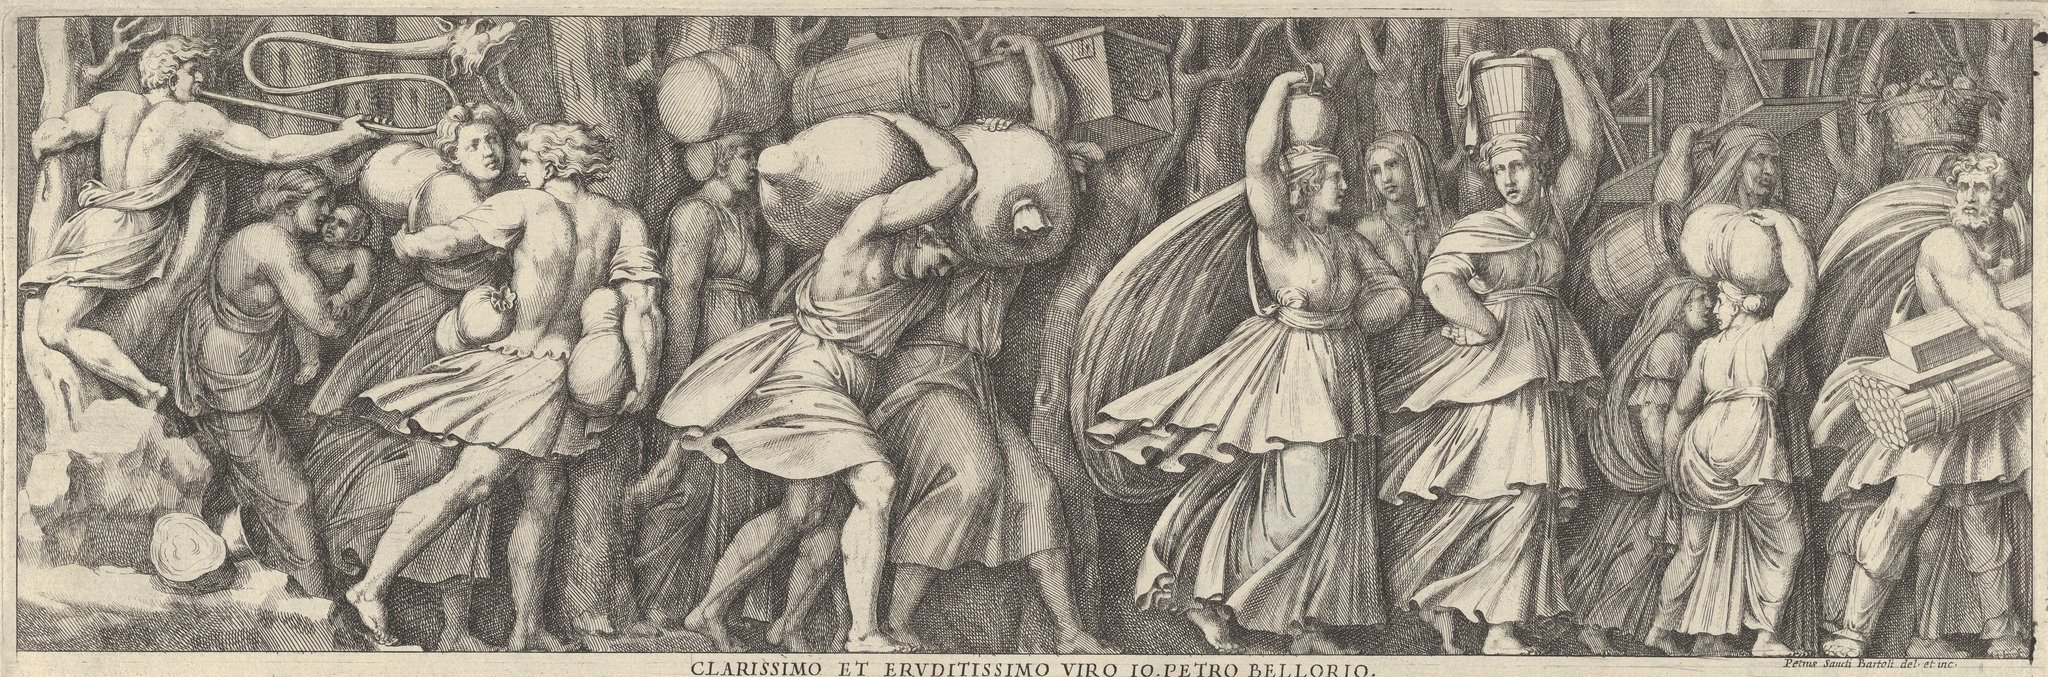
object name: print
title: Plate 1: A Procession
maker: pietro santi bartoli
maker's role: artist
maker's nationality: italian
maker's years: 1615-1700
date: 1660-1690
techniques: etching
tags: men,women,processions